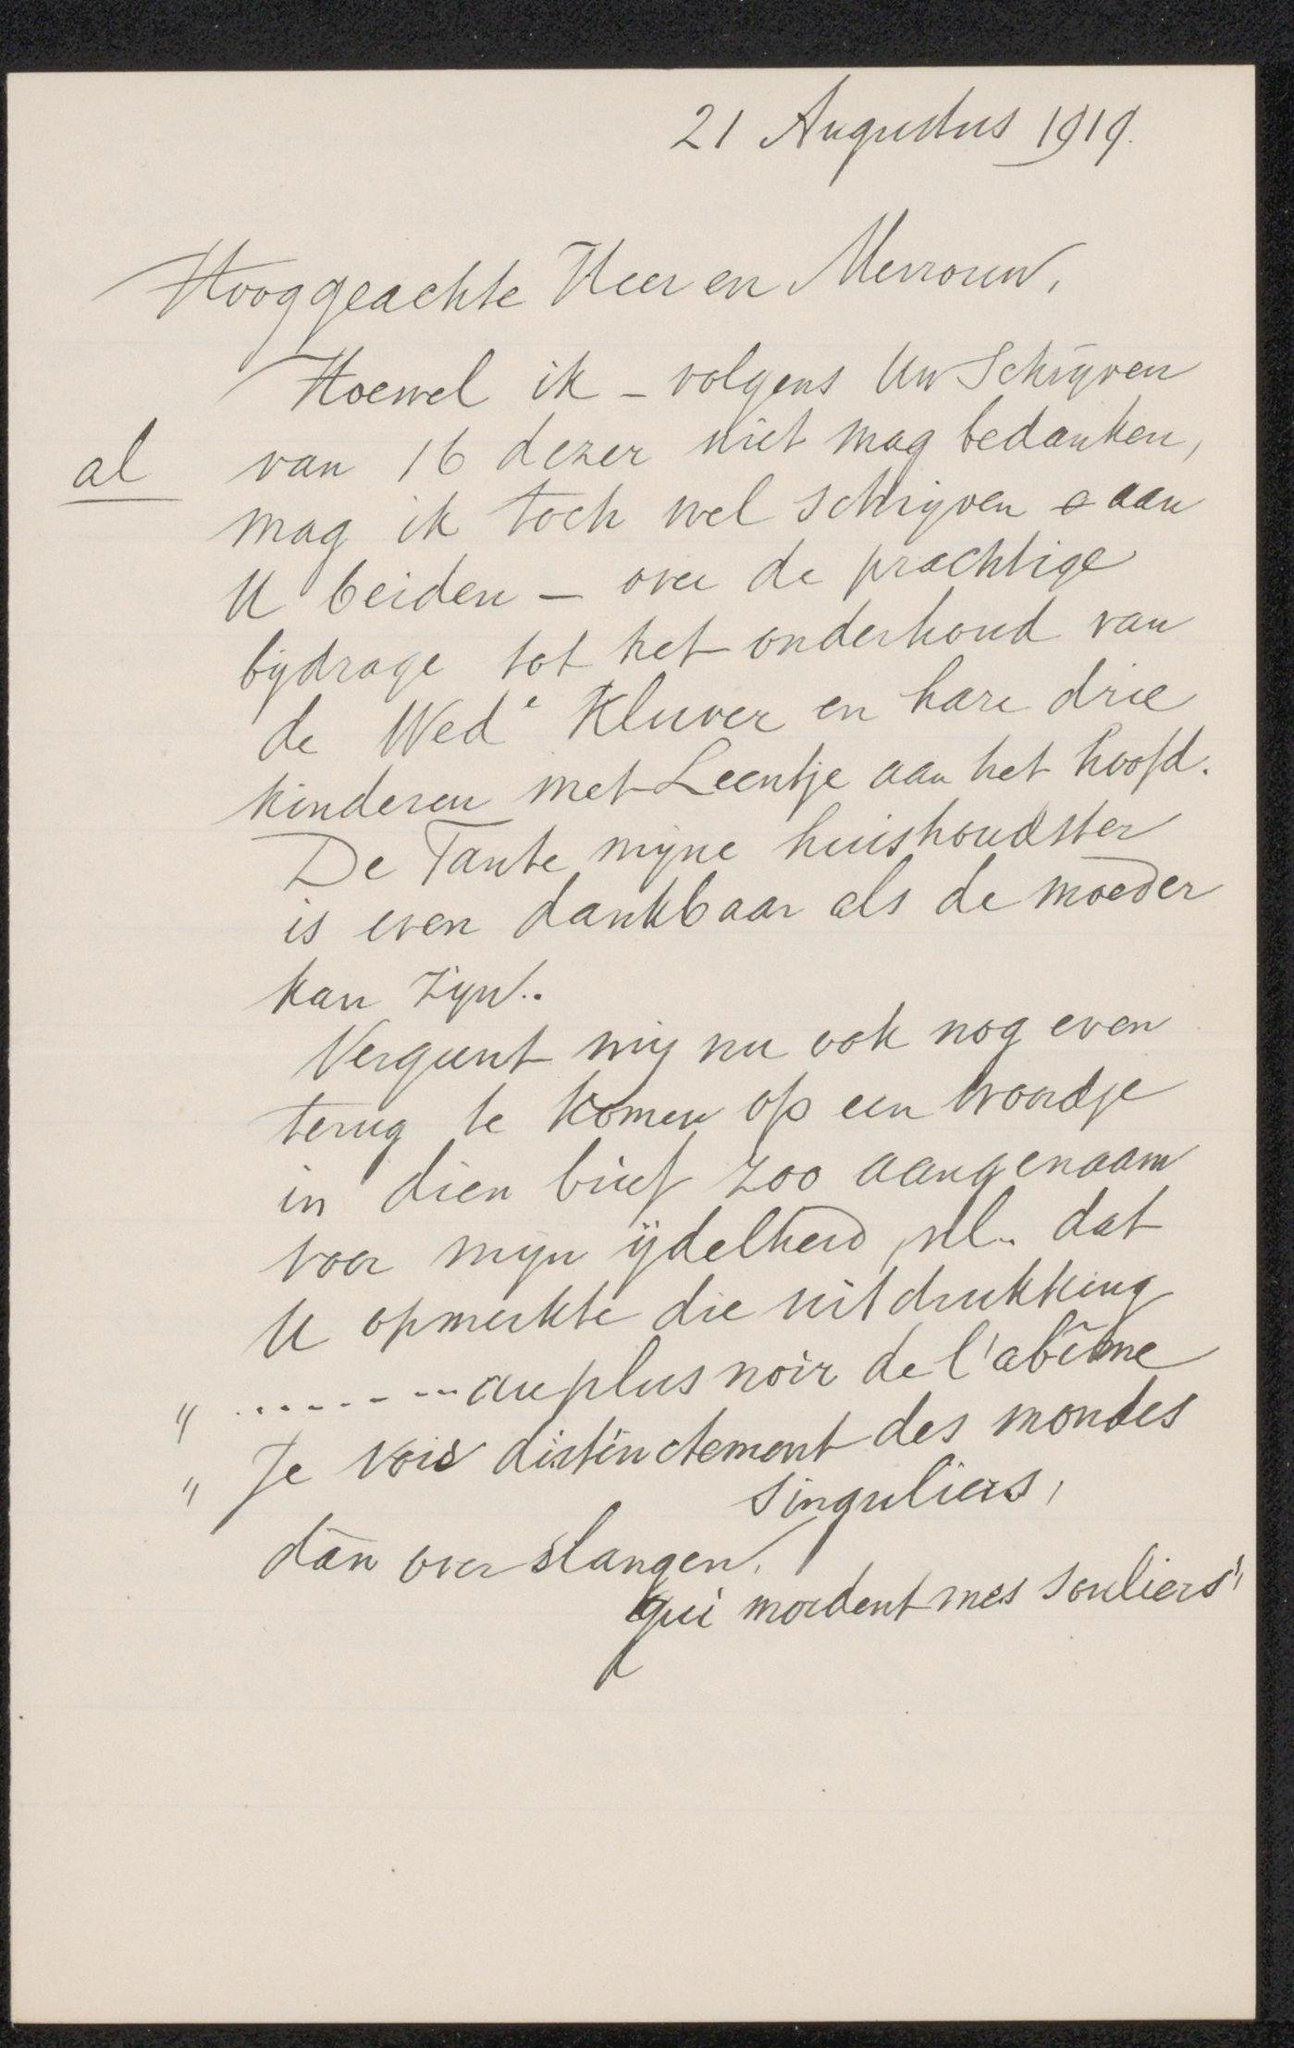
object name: letter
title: Brief aan Max Wilhelm Carl Weber en Anne Antoinette Weber-Van Bosse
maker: august allebé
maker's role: draughtsman, print maker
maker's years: 1838-1927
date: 1919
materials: ink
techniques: pen, writing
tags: amsterdam, anne antoinette weber-van bosse, paris, charles baudelaire, everhardus johannes potgieter, johann wolfgang von goethe, edgar allan poe, literature ~ arts, charitable works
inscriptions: watermark